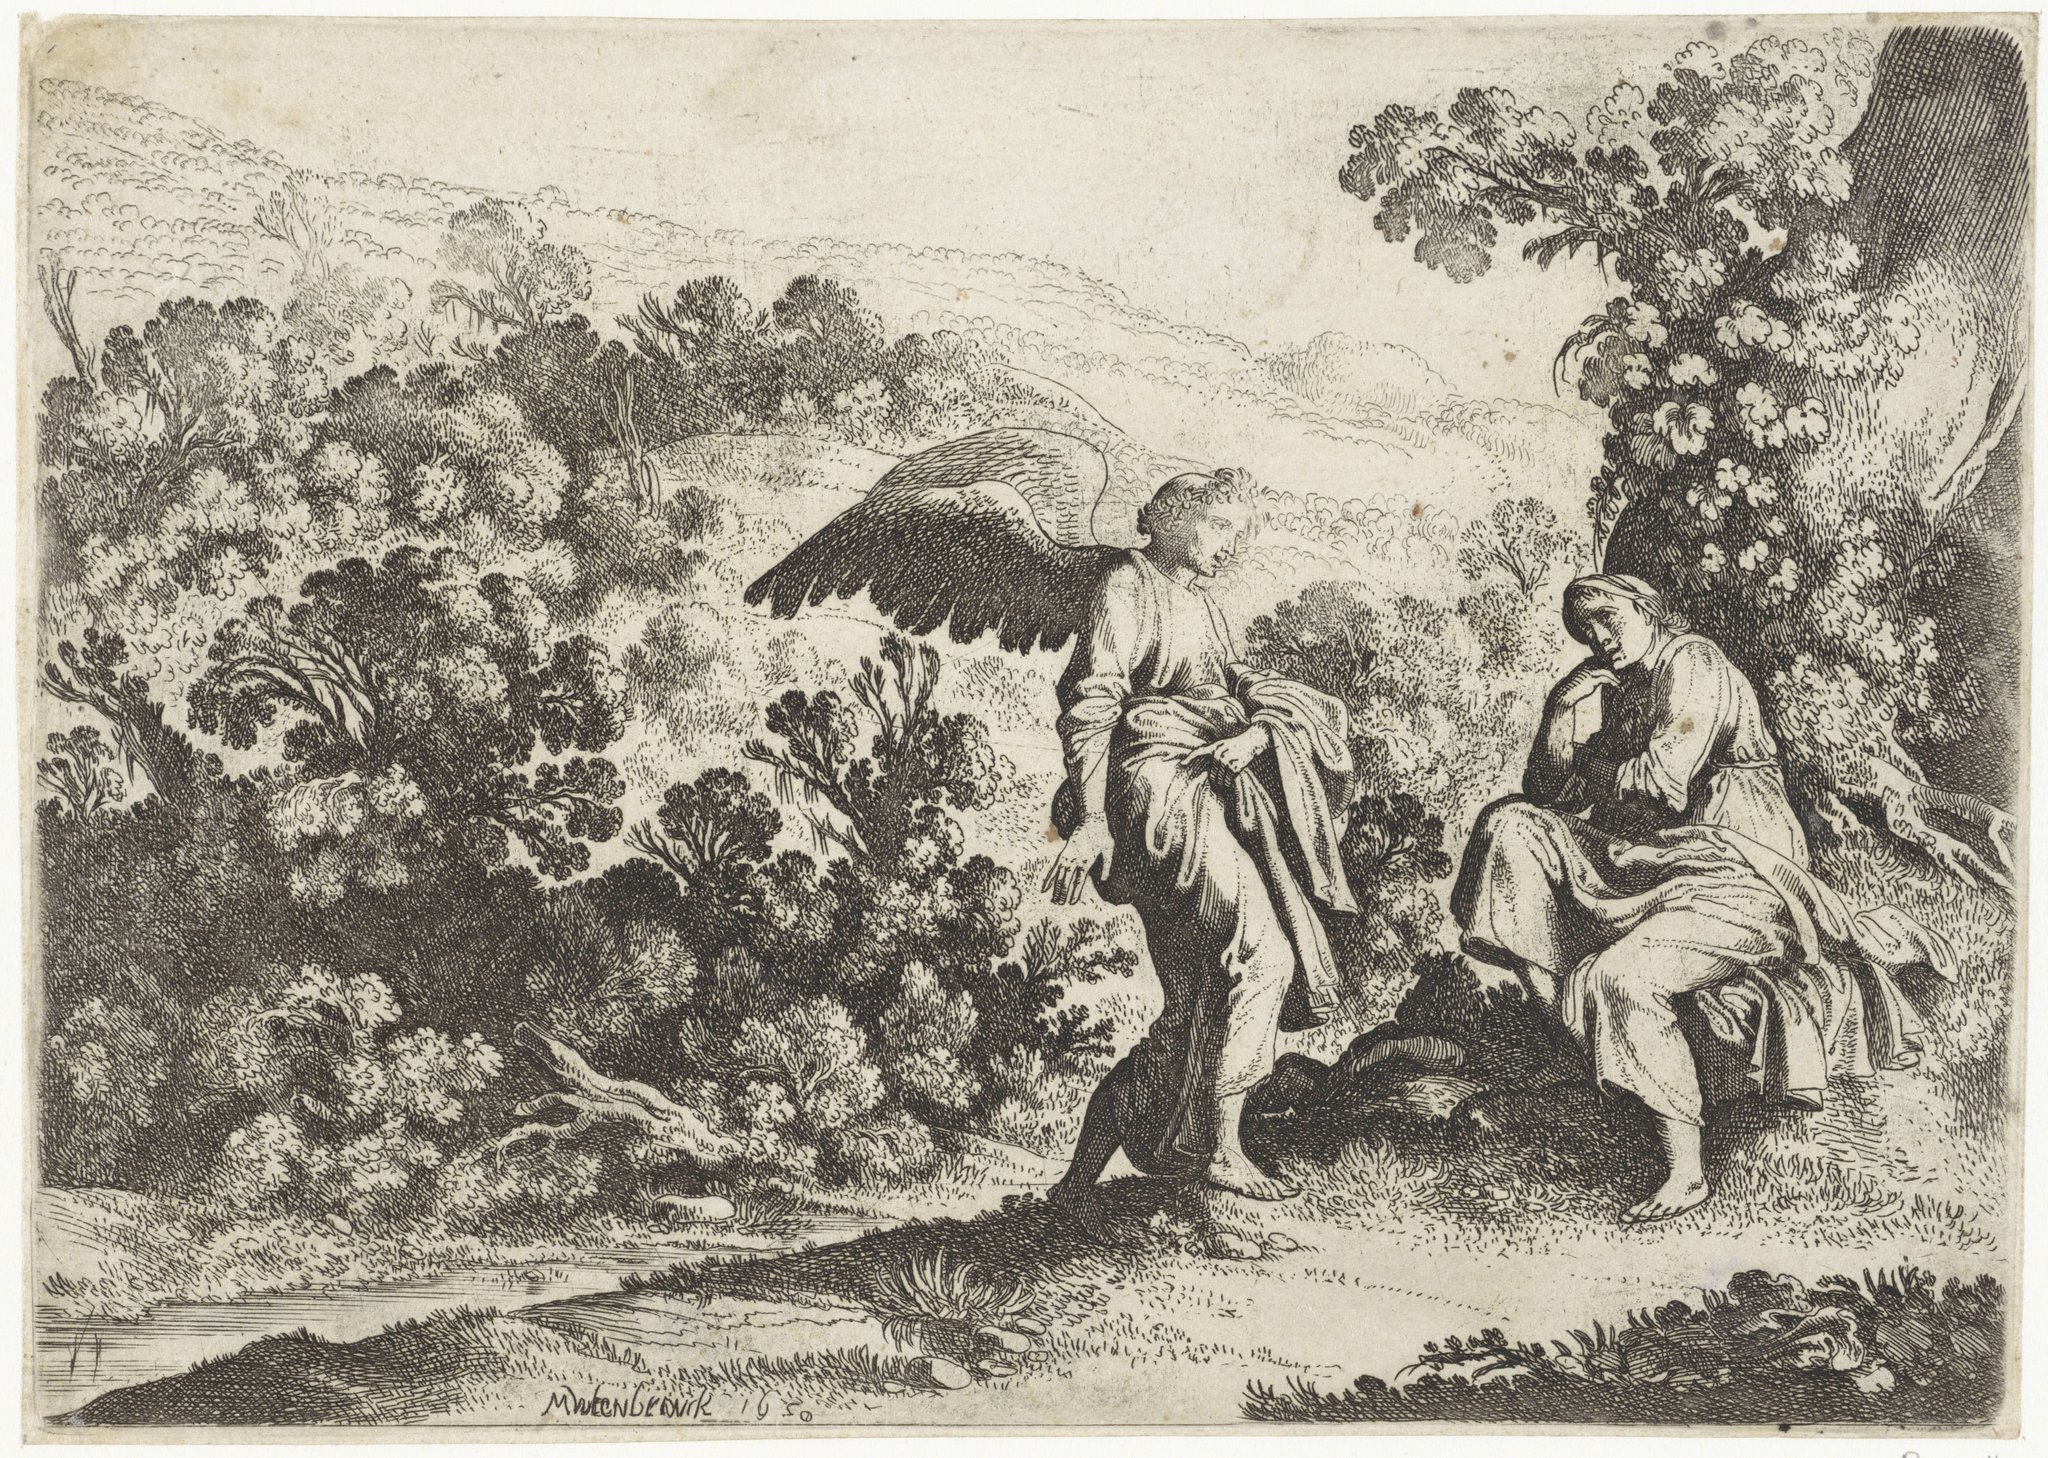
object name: print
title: De engel troost Hagar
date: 1620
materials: paper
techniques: engraving, etching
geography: the hague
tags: an angel meets hagar at the fountain on the way to shur and persuades her to return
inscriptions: collector's mark: Lugt 356b, collector's mark: Lugt 700a, collector's mark: Lugt 1938, collector's mark: Lugt 2760, collector's mark:, collector's mark: Lugt 2228, collector's mark: Lugt 2318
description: Hagar zit aan de voet van een dikke boom in een heuvellandschap. De engel loopt naar haar toe. In de linkerbenedenhoek genummerd als II.